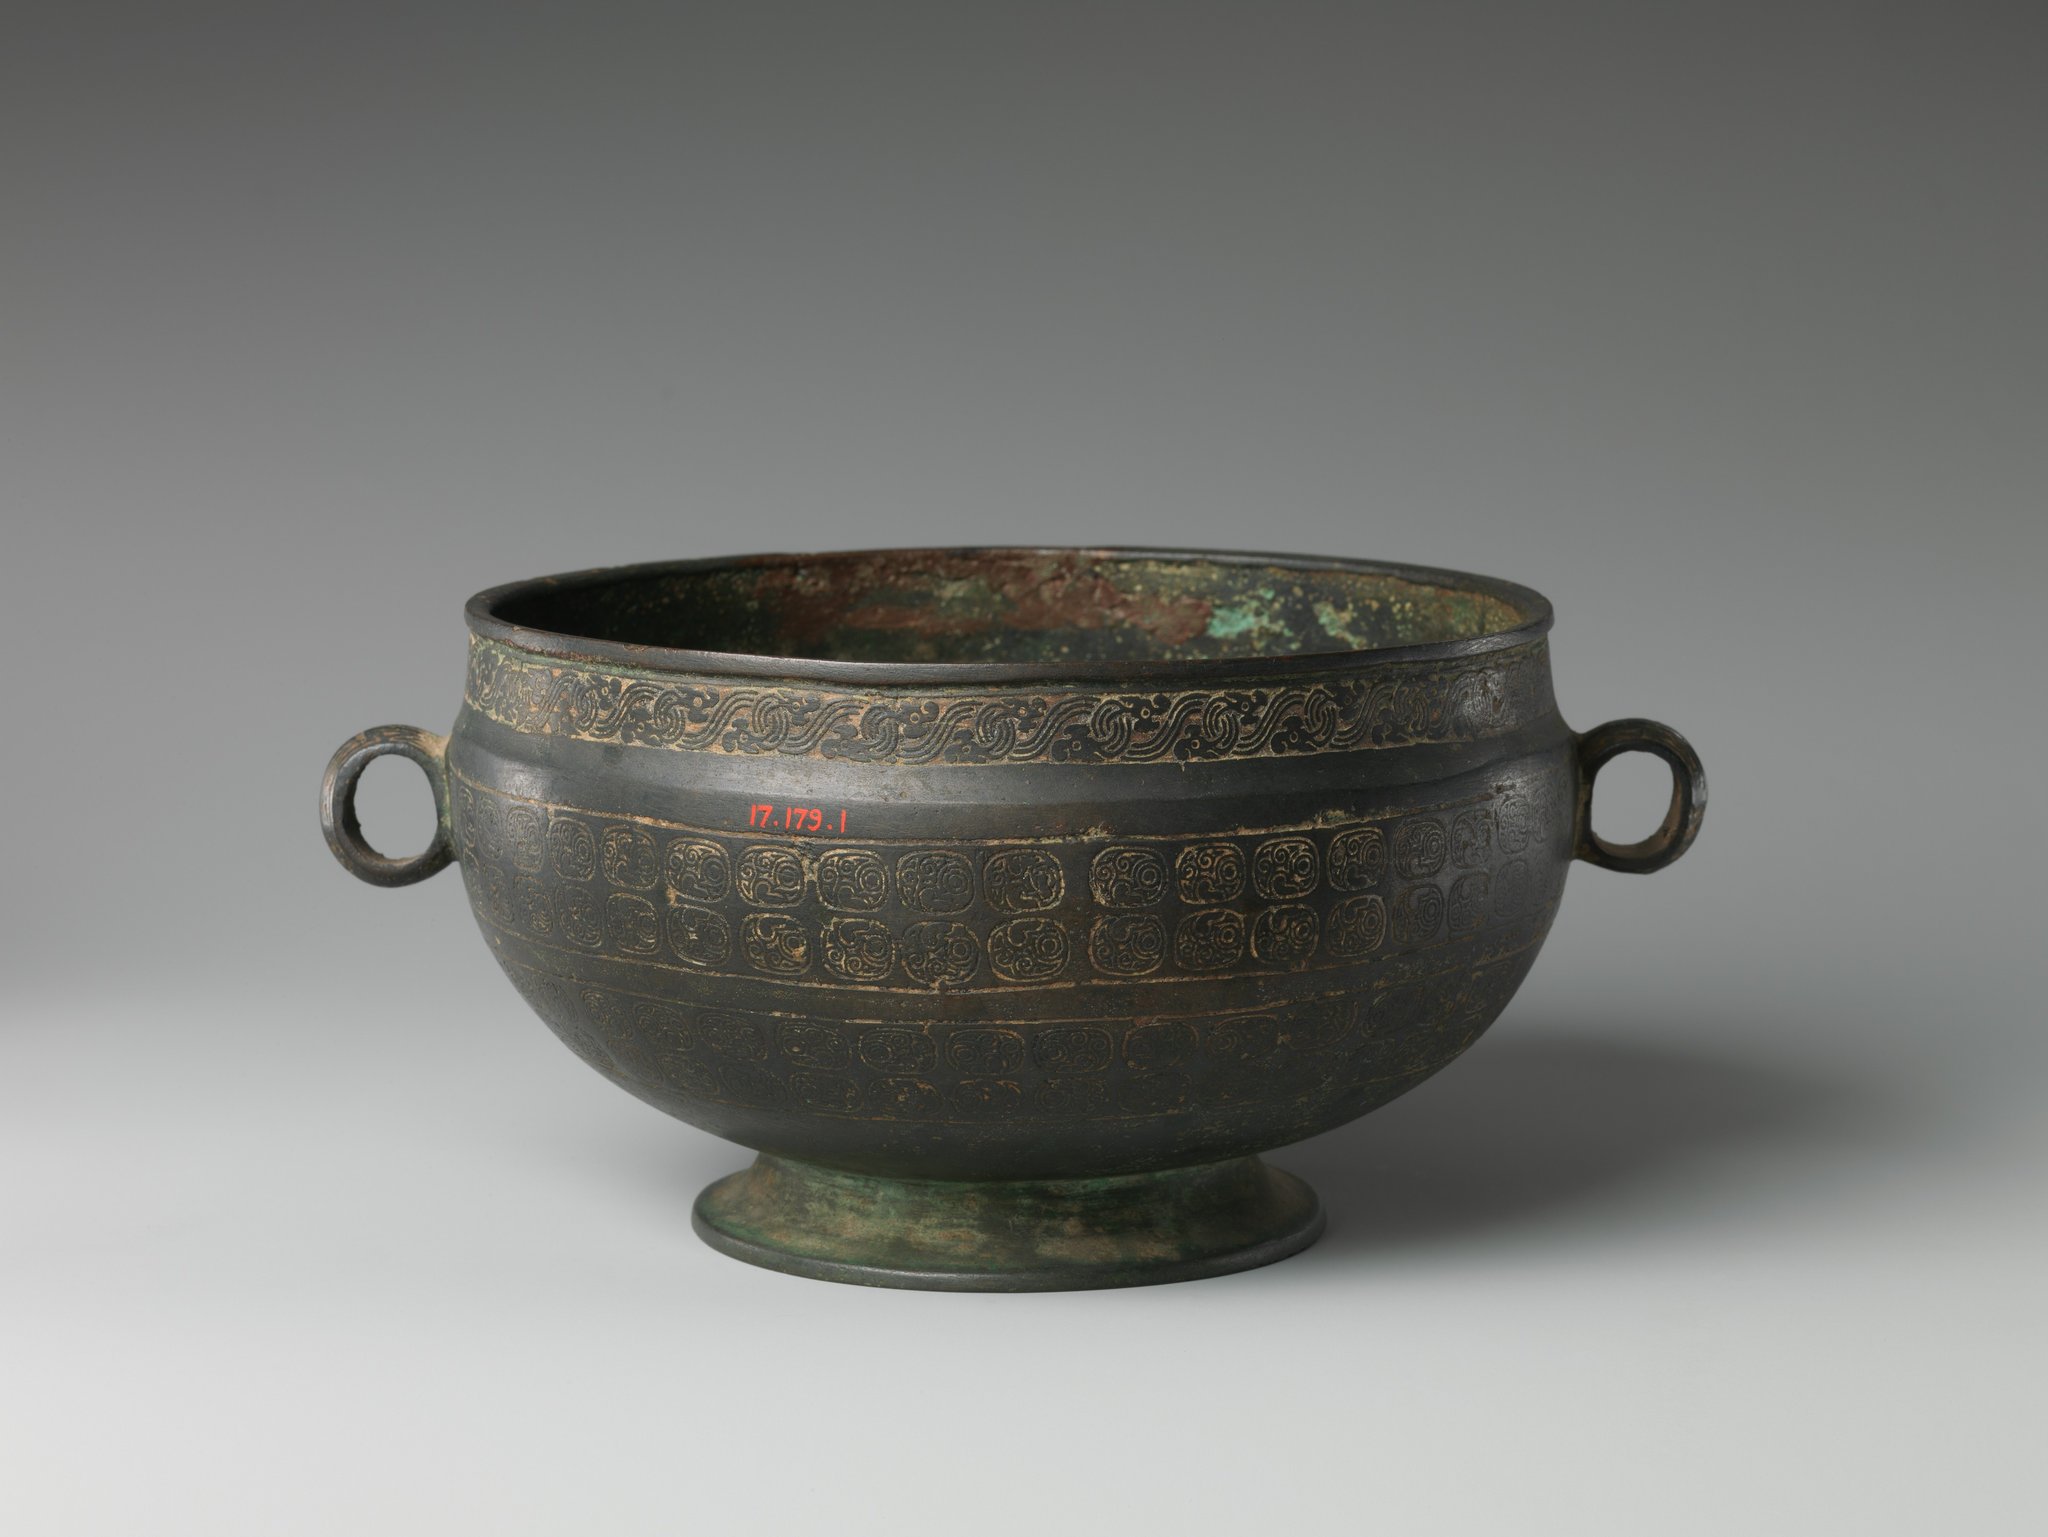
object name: bowl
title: Bowl with ring handles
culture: chinese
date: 101-300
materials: bronze